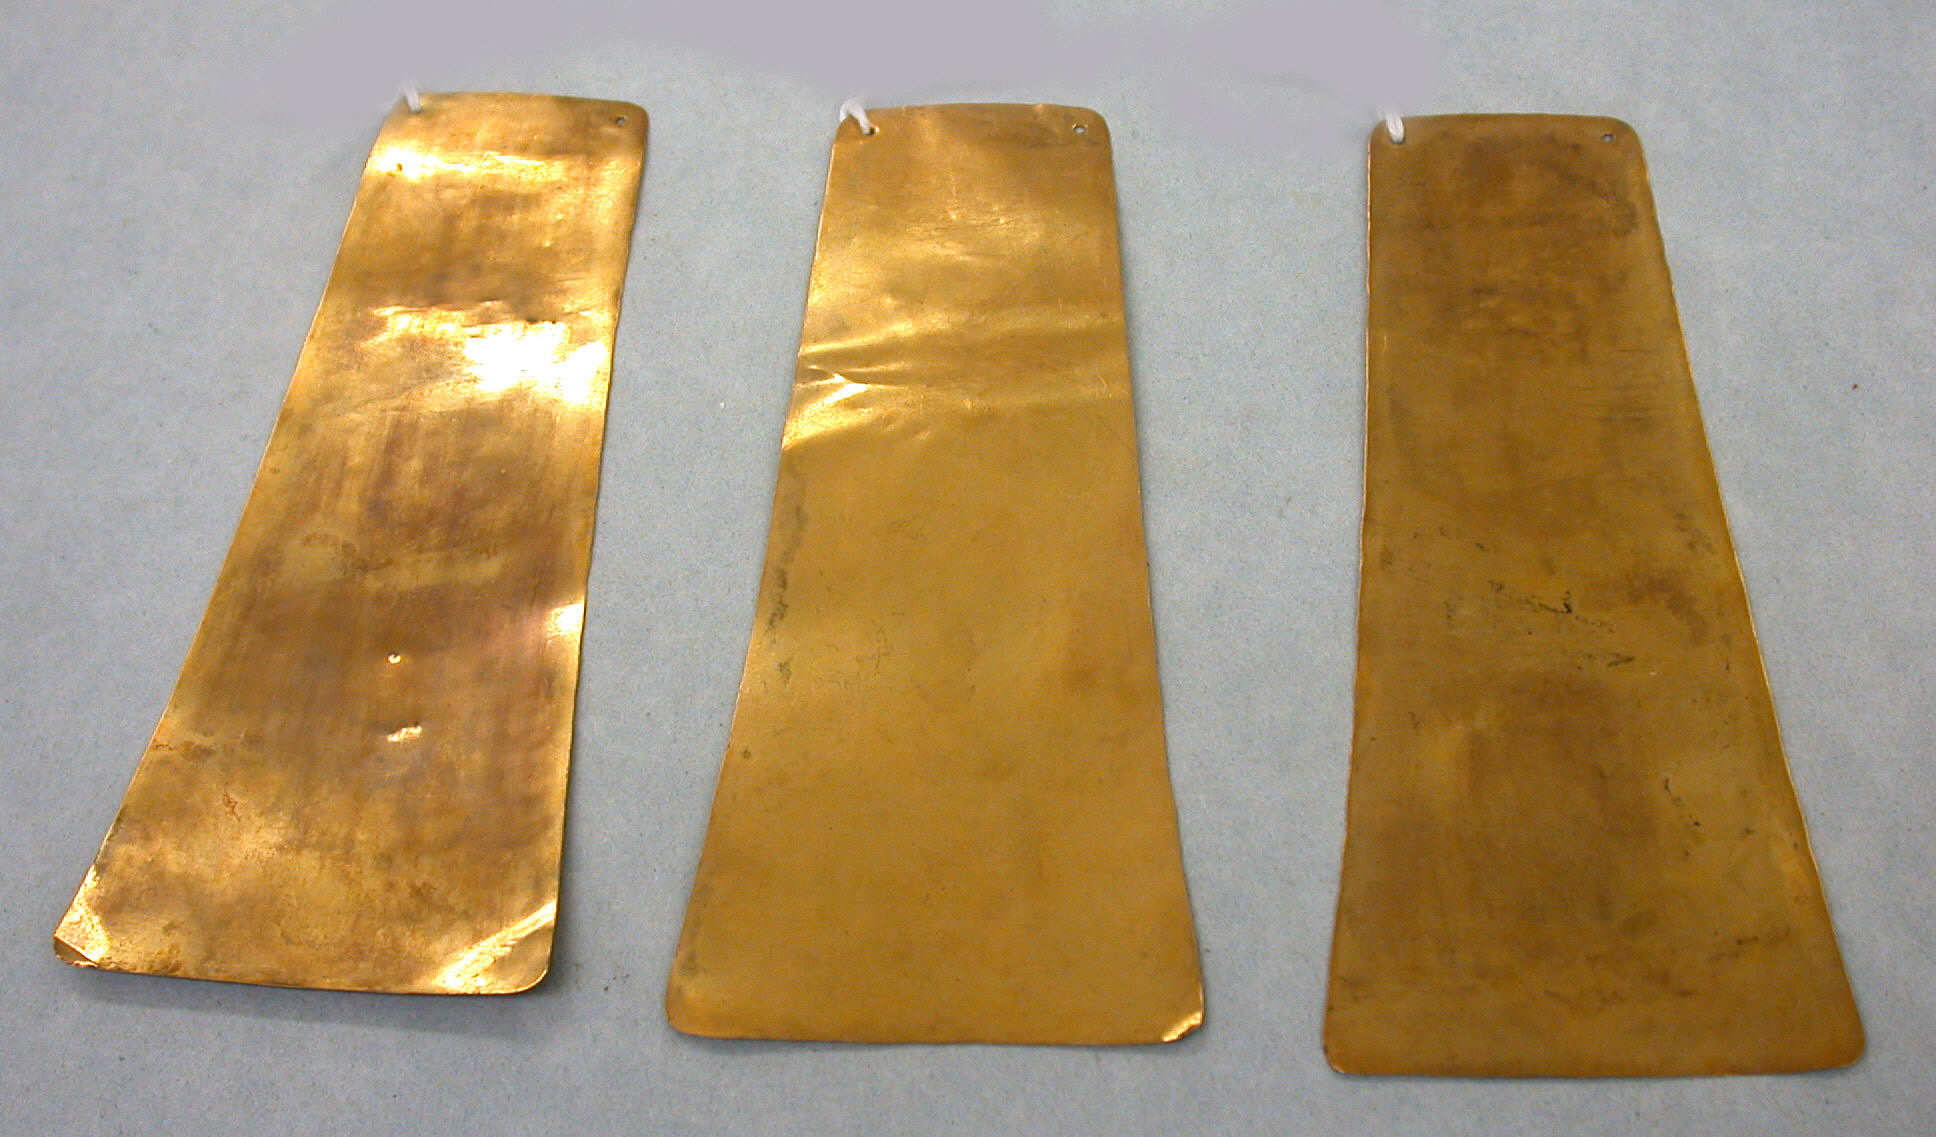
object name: ornament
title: Tab Ornament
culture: salinar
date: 100 BCE-200 CE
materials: gold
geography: peru